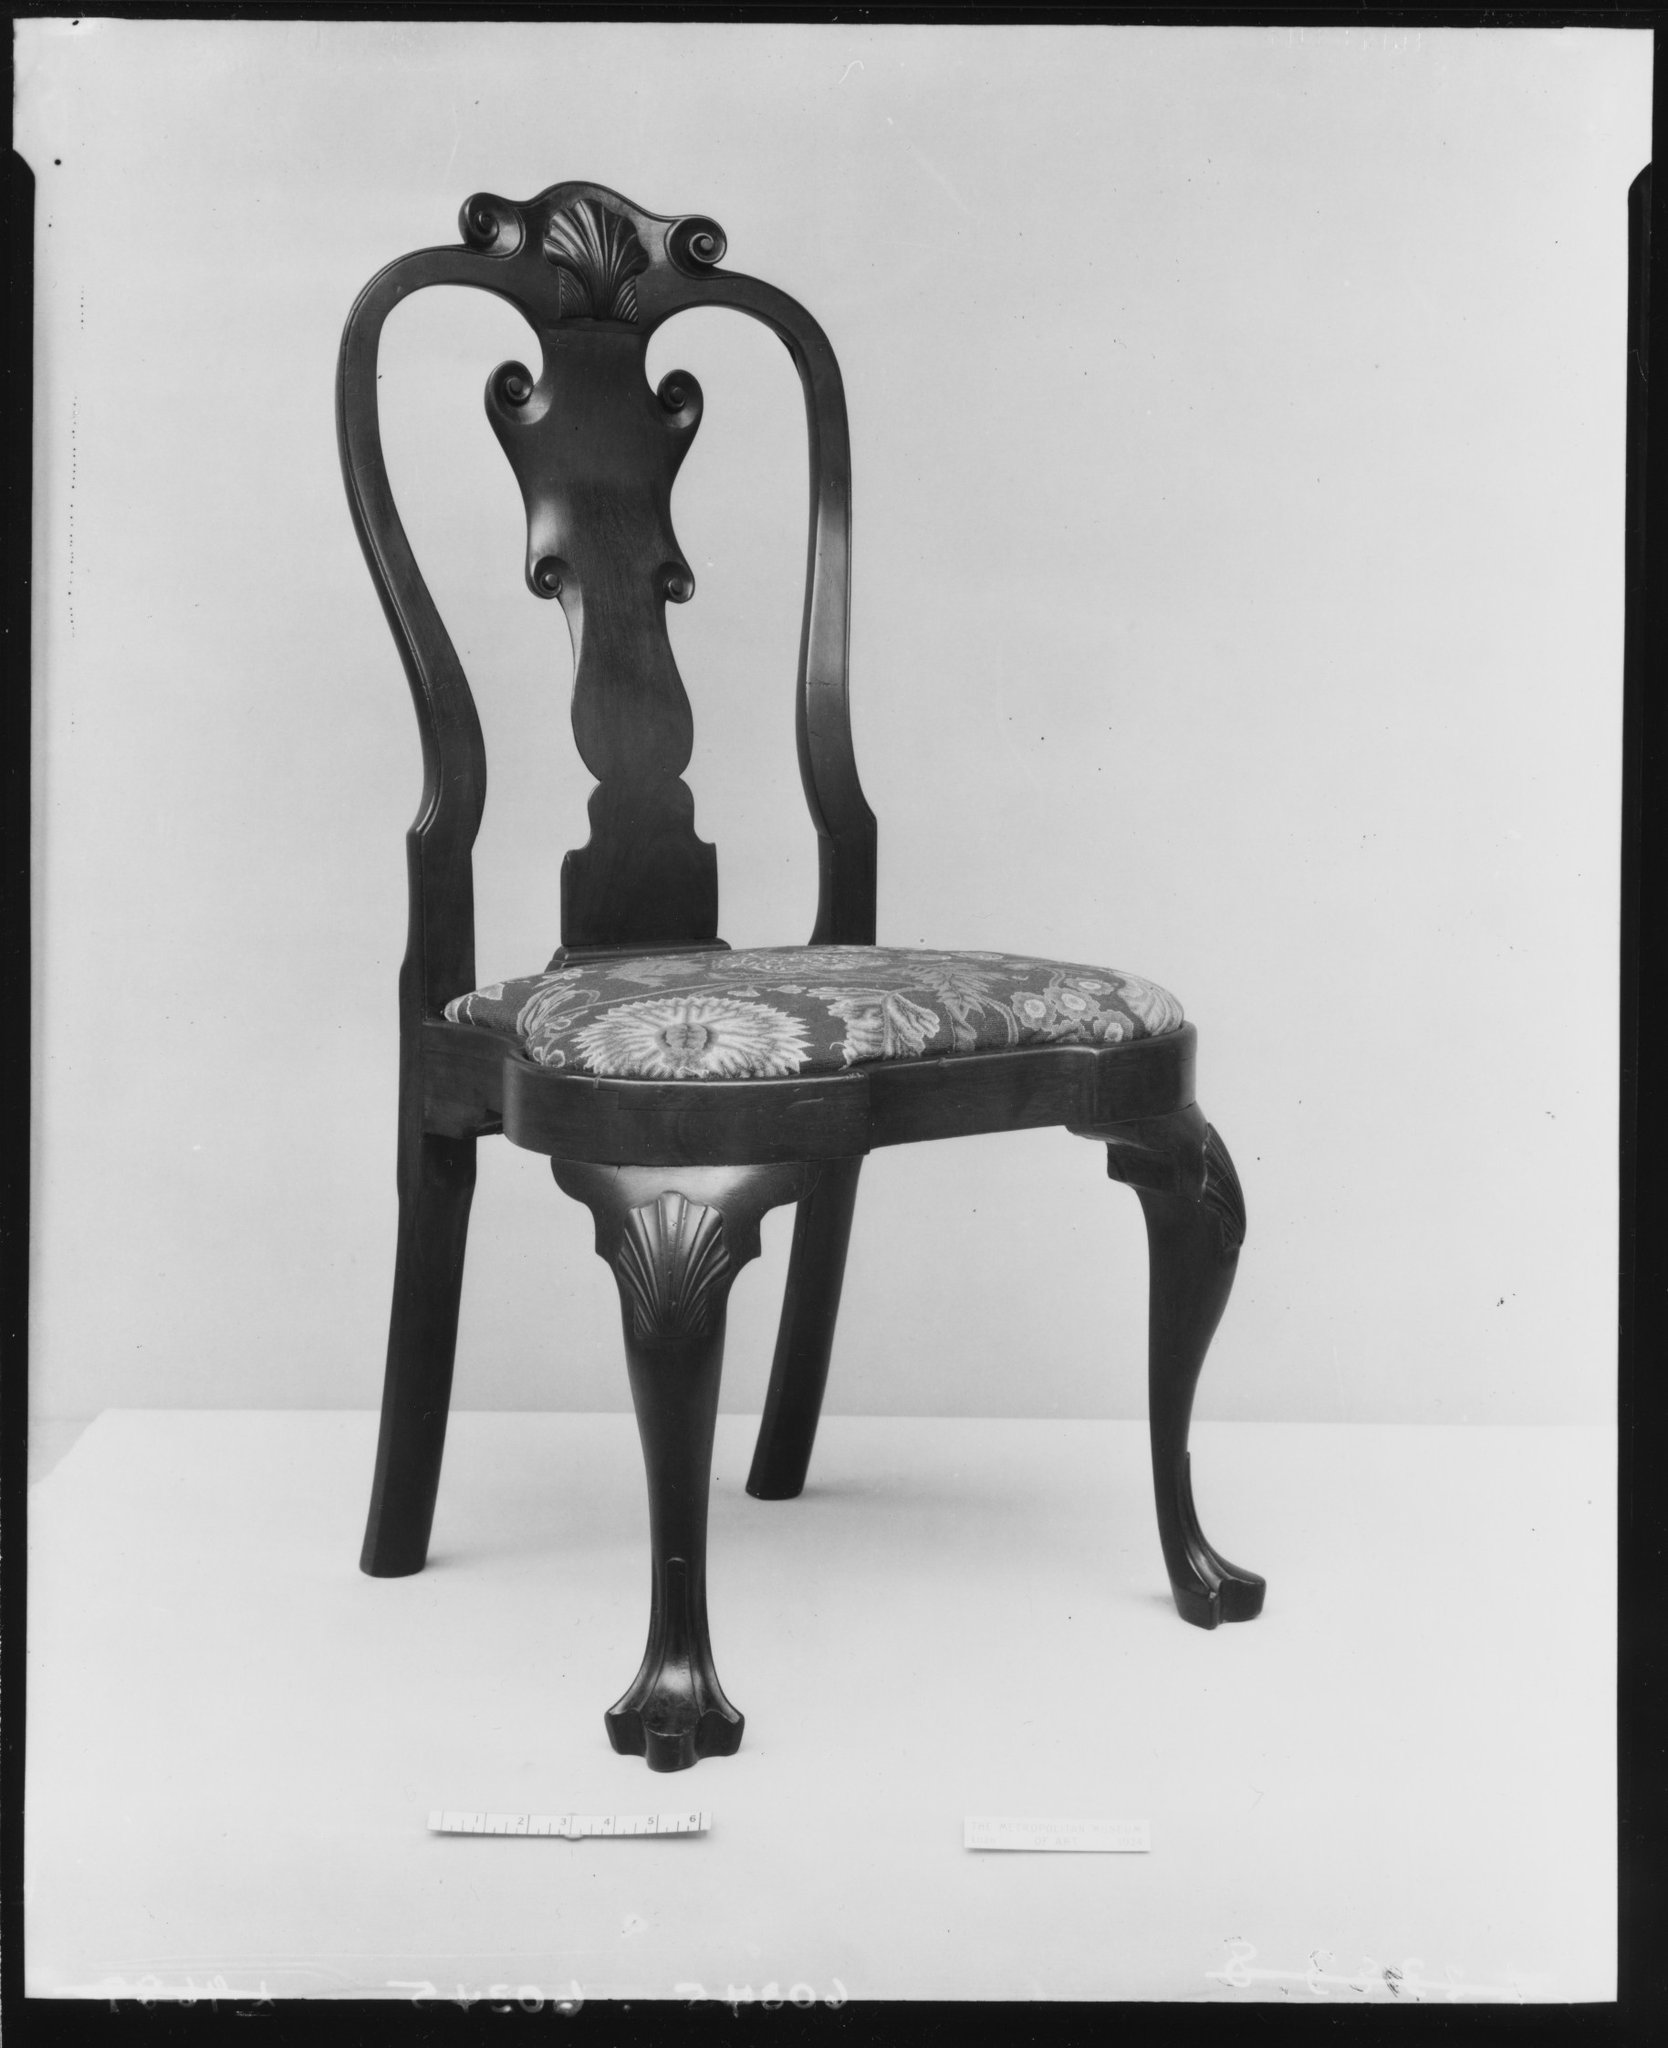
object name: side chair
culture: american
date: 1750-1775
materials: wood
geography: united states